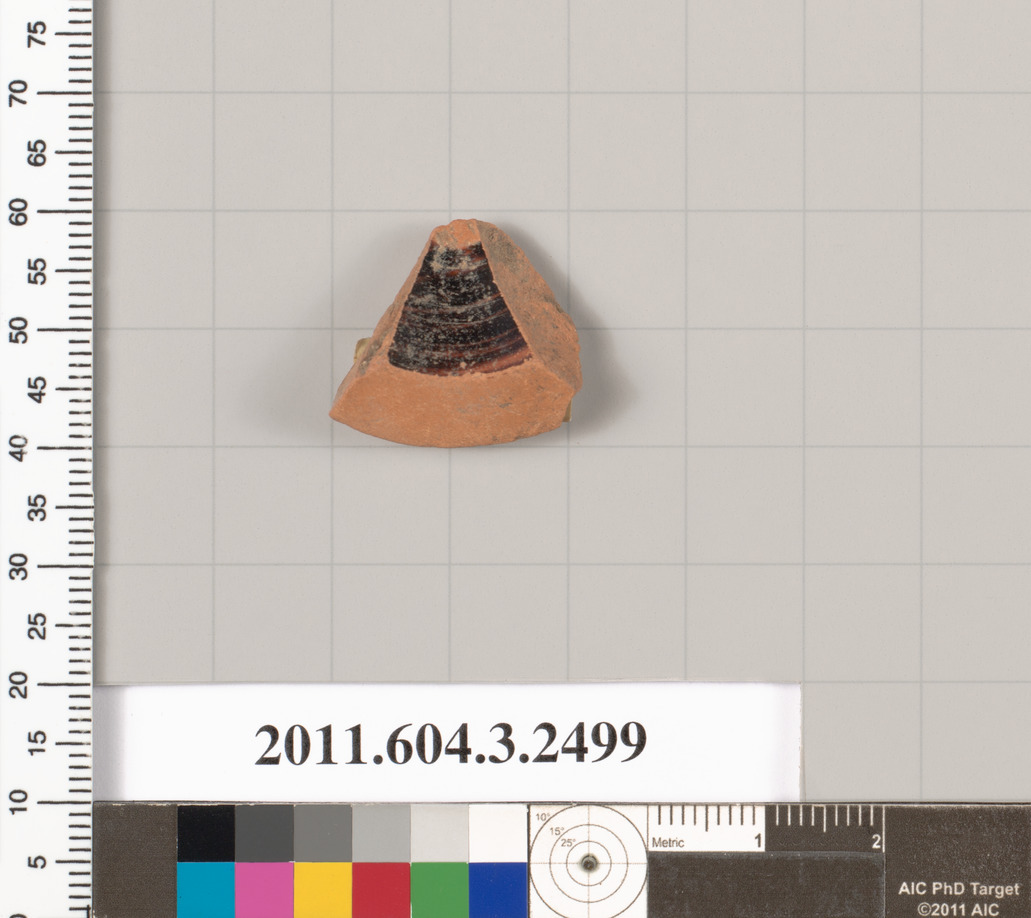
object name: kylix or lekythos fragment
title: Terracotta fragment of a kylix (drinking cup) or a lekythos (oil flask)?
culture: greek, attic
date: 600-401 BCE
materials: terracotta